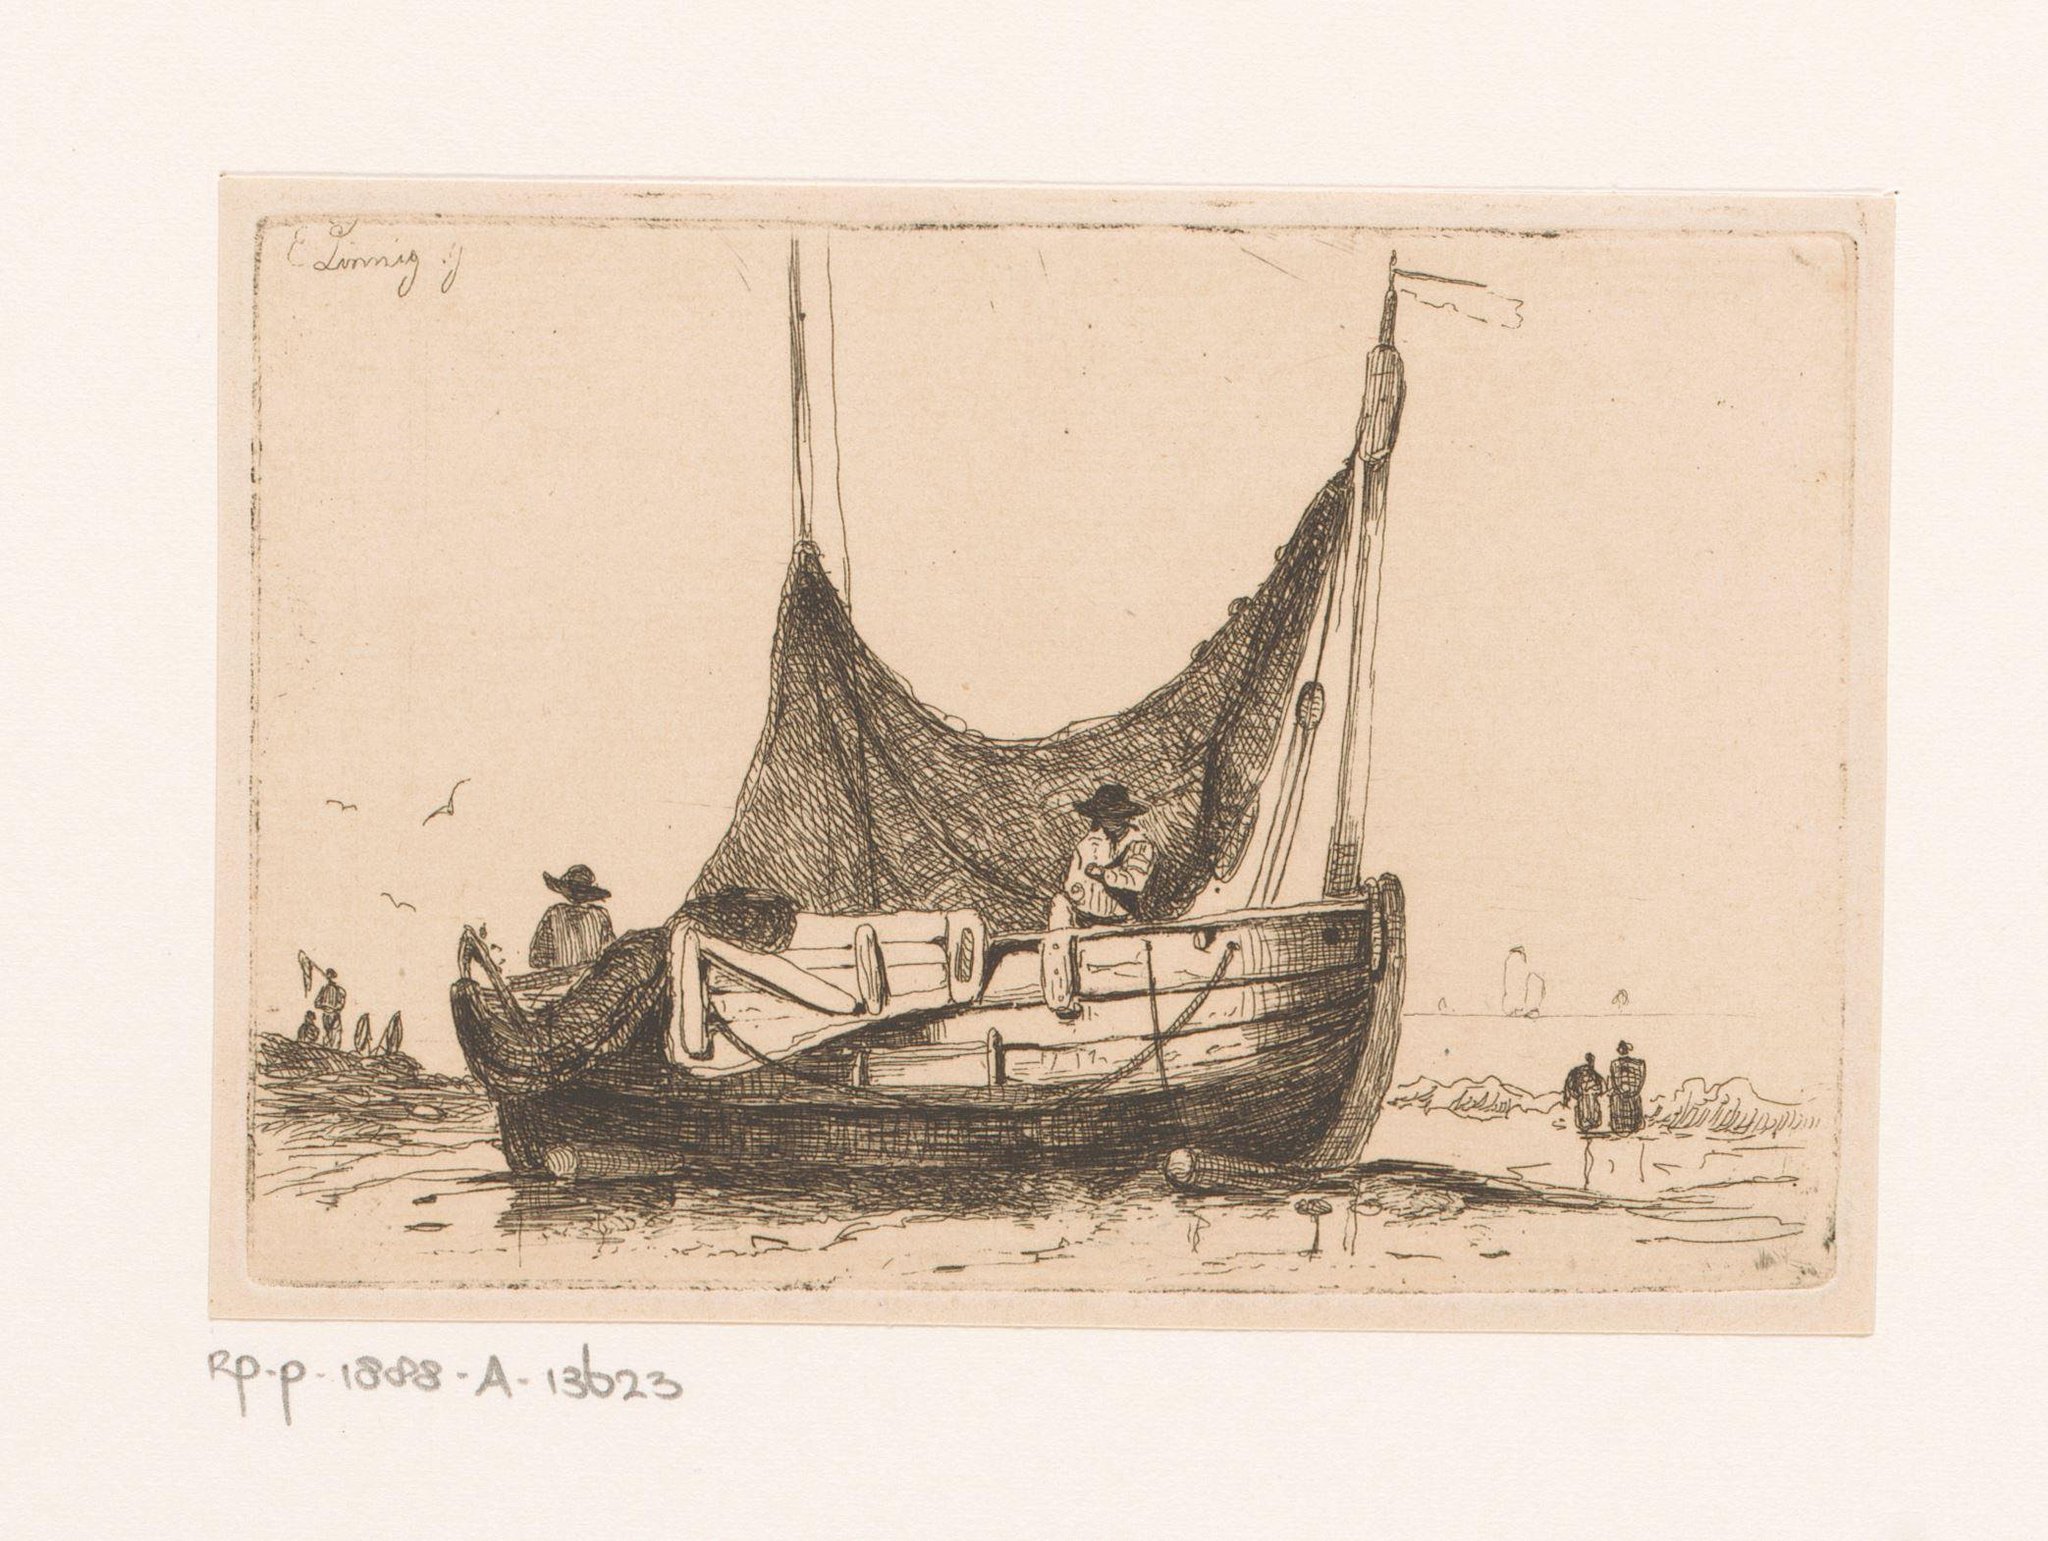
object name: print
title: Vissersboot uit Blankenberge op rollen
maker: egidius linnig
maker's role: draughtsman, print maker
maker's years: 1821-1860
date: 1831-1860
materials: paper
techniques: etching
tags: sailing-ship, sailing-boat, ships, boats on land, beached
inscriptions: collector's mark: Lugt 2228